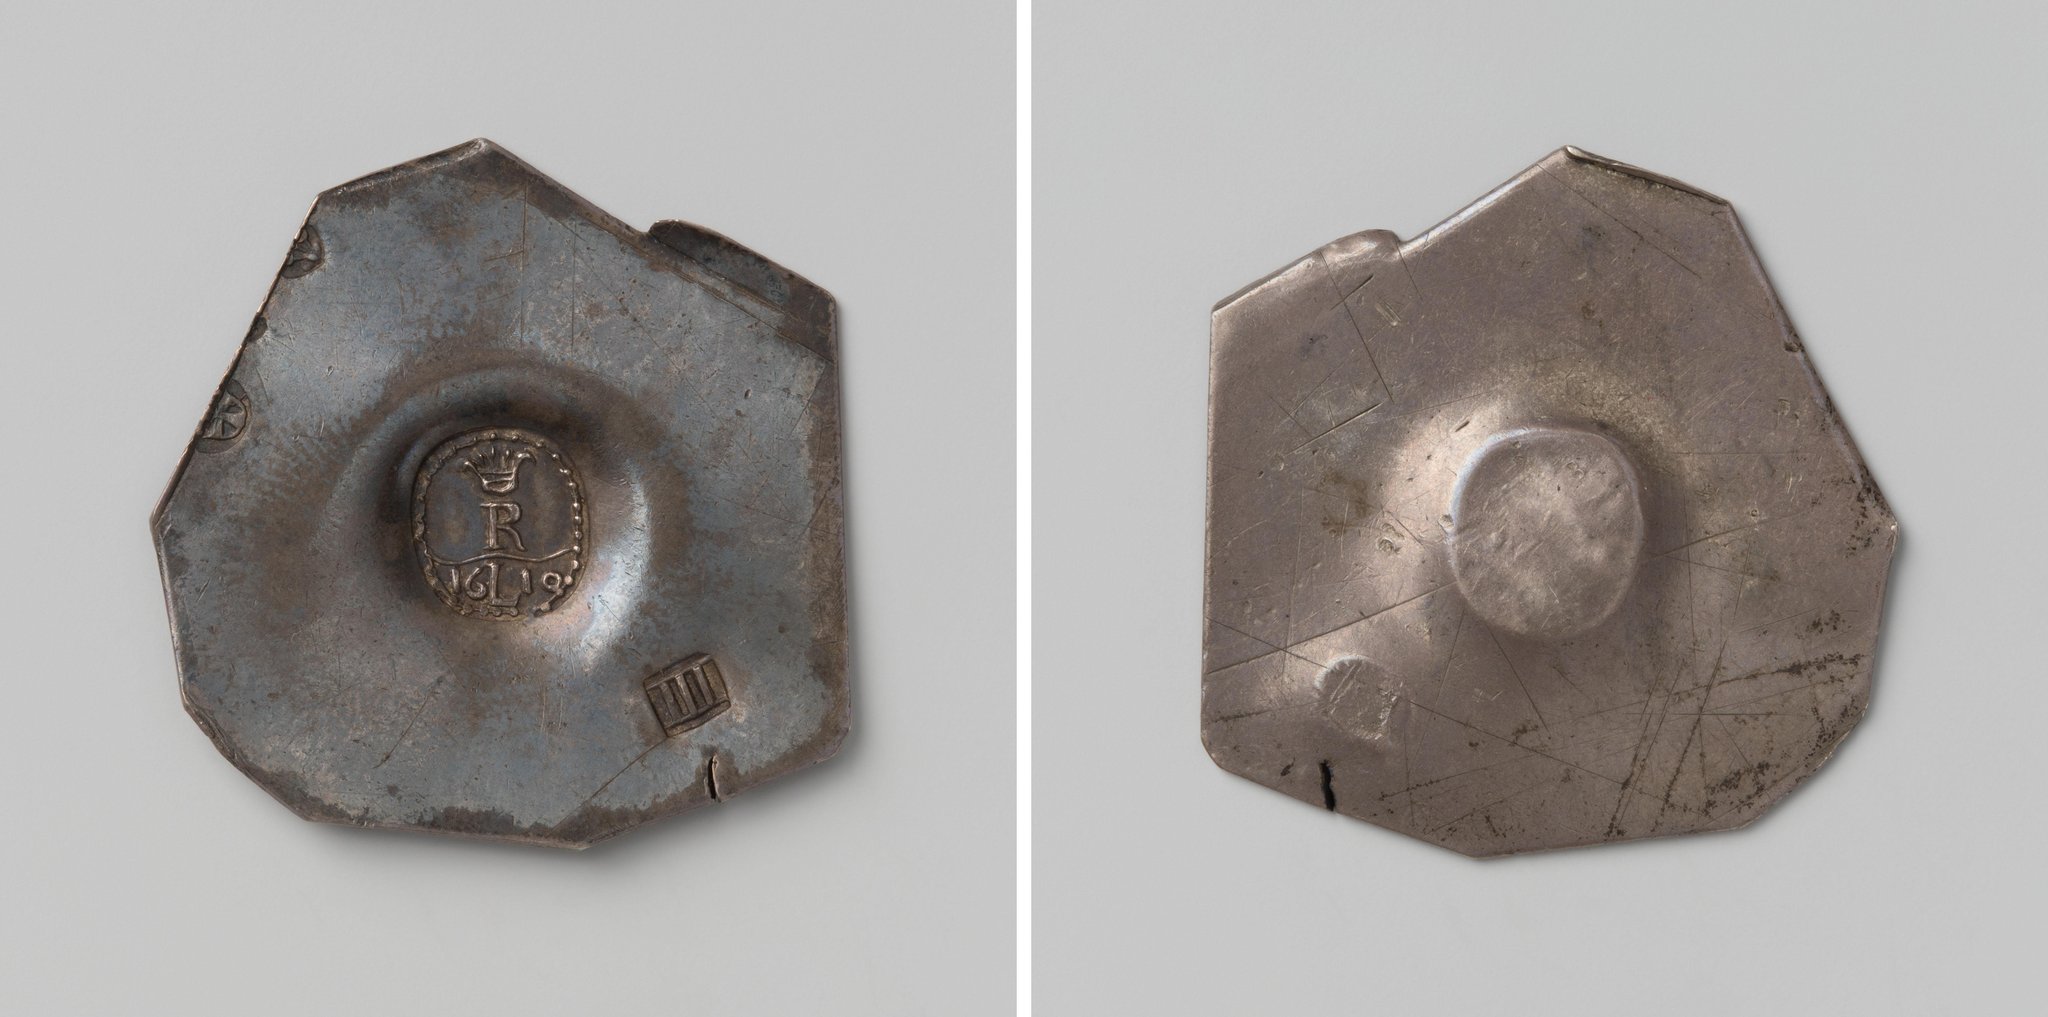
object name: siege coin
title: Drie eenheden, kopie van een noodmunt uit Gulik, geslagen tijdens het beleg door Maurits, prins van Oranje-Nassau, vervaardigd door stukken te knippen uit serviesgoed en bestempeld met het monogram van Rudolf II, Duits keizer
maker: Anonymous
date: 1610-1883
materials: silver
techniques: striking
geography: germany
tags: the hague, maurice (prince of orange), vienna, prague, rudolf ii van habsburg (duits keizer)